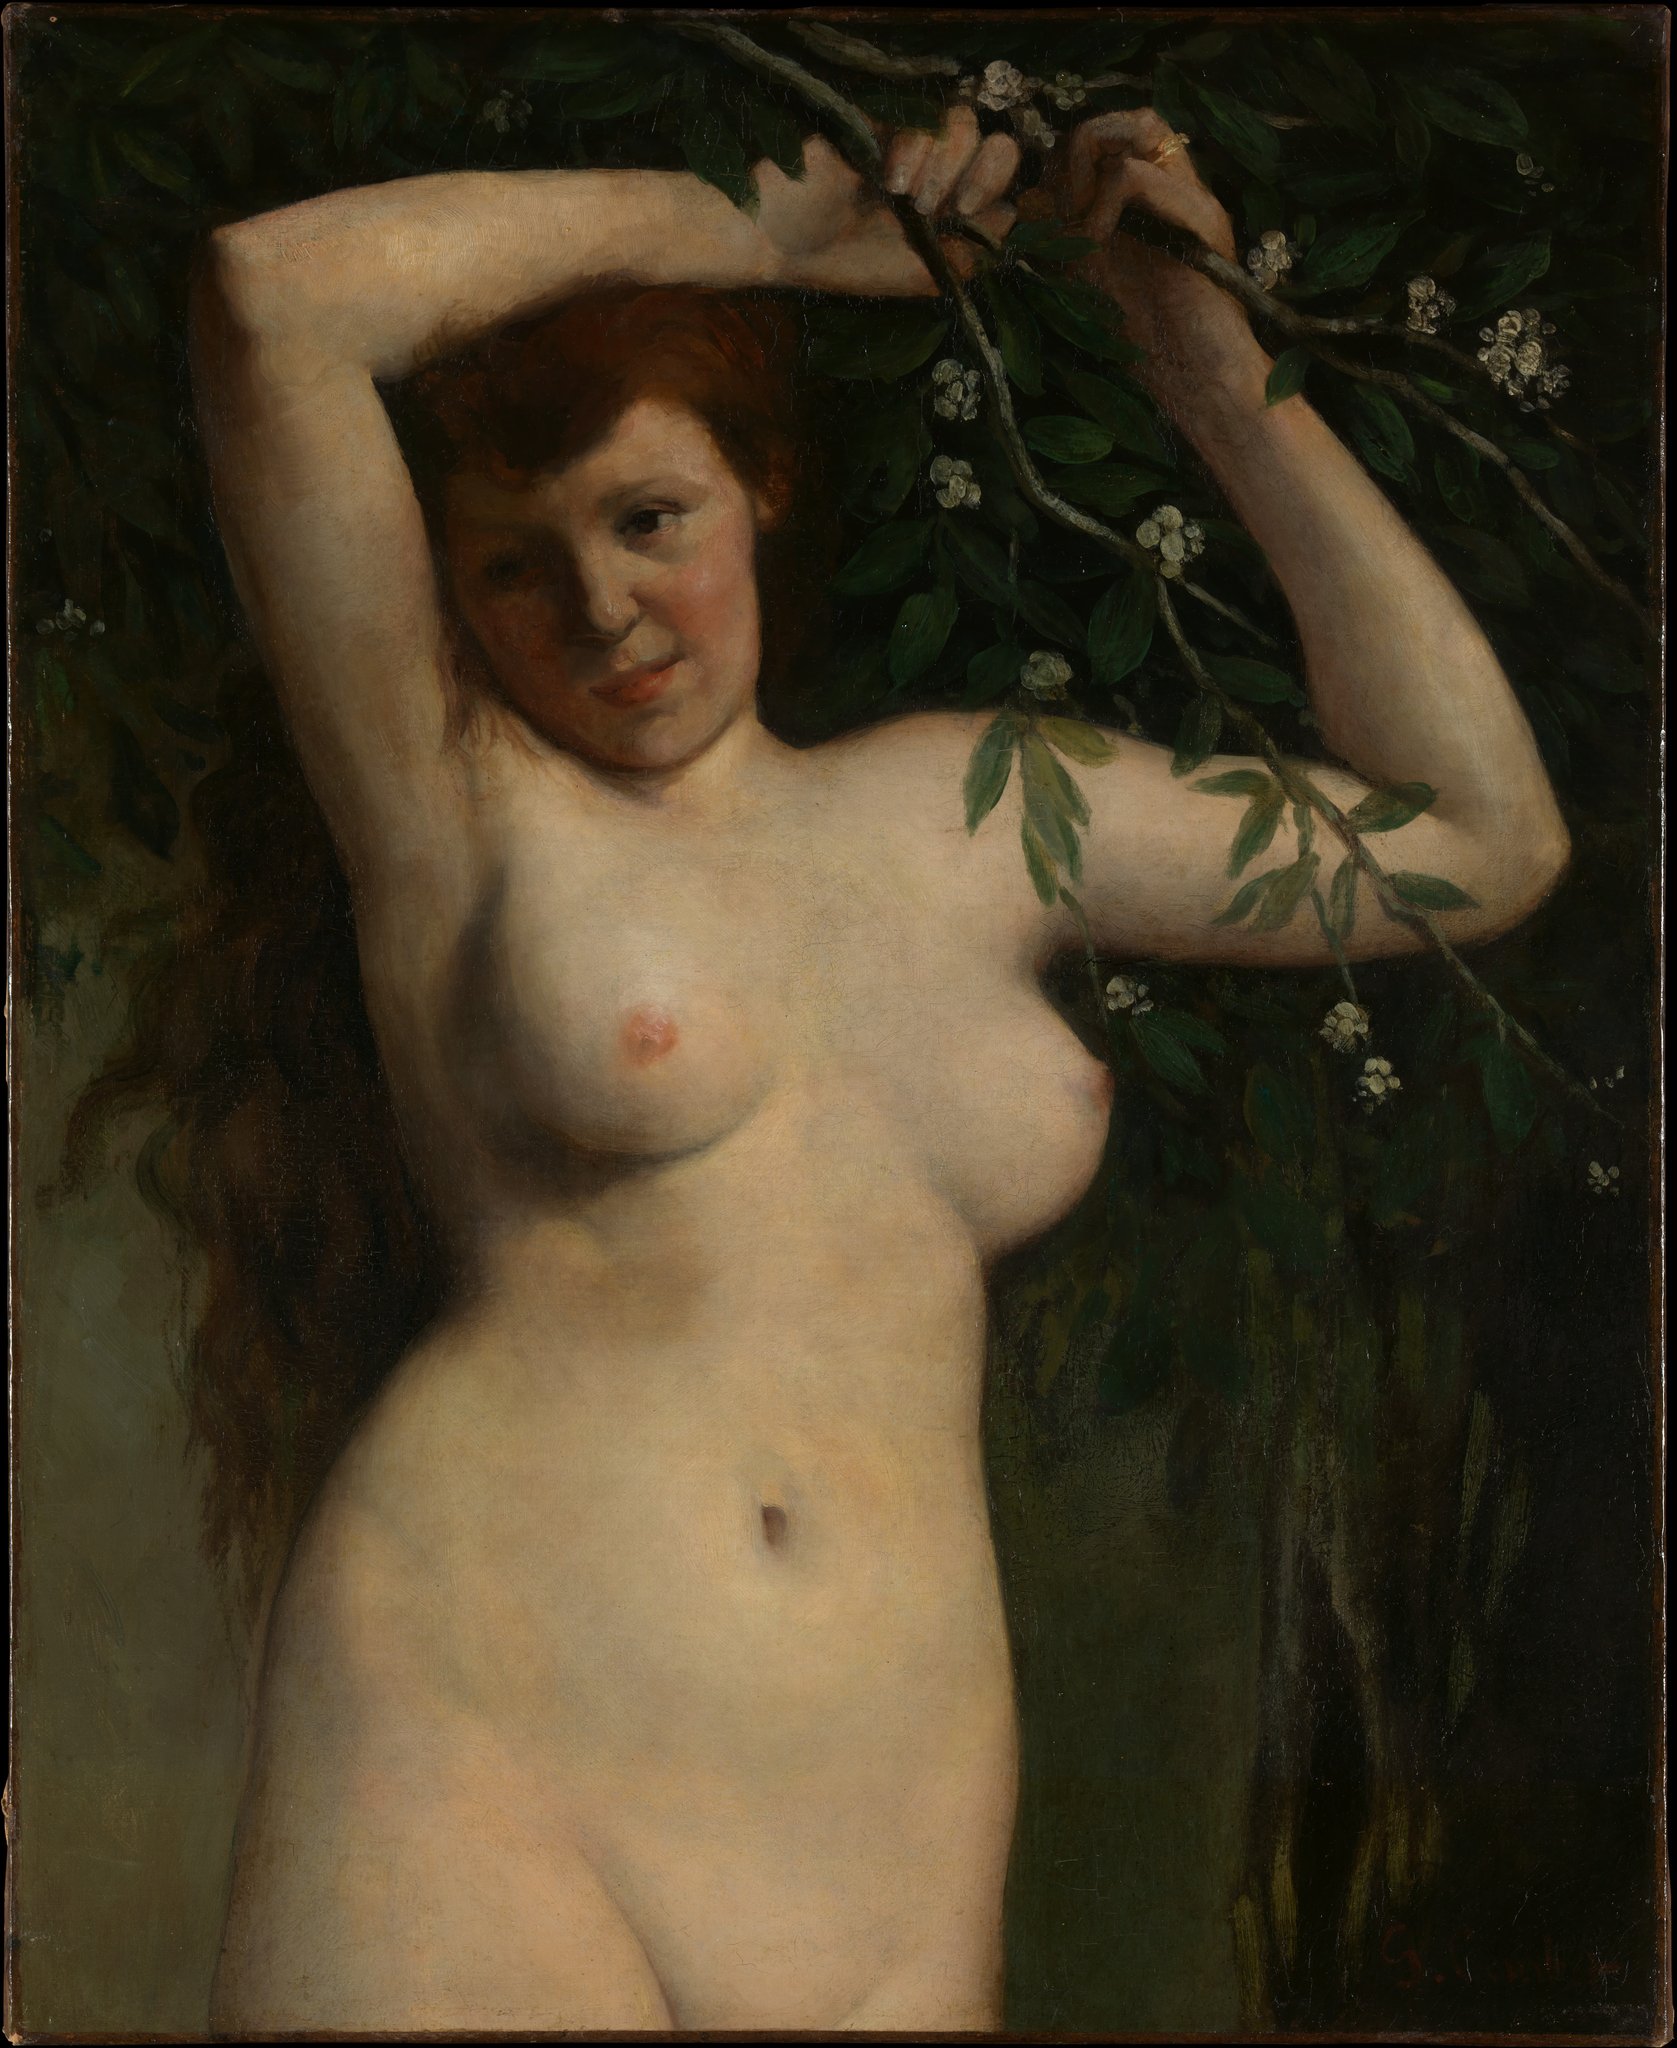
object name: painting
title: Nude with Flowering Branch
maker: gustave courbet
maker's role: artist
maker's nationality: french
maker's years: 1819-1877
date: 1863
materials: canvas, oil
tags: female nudes